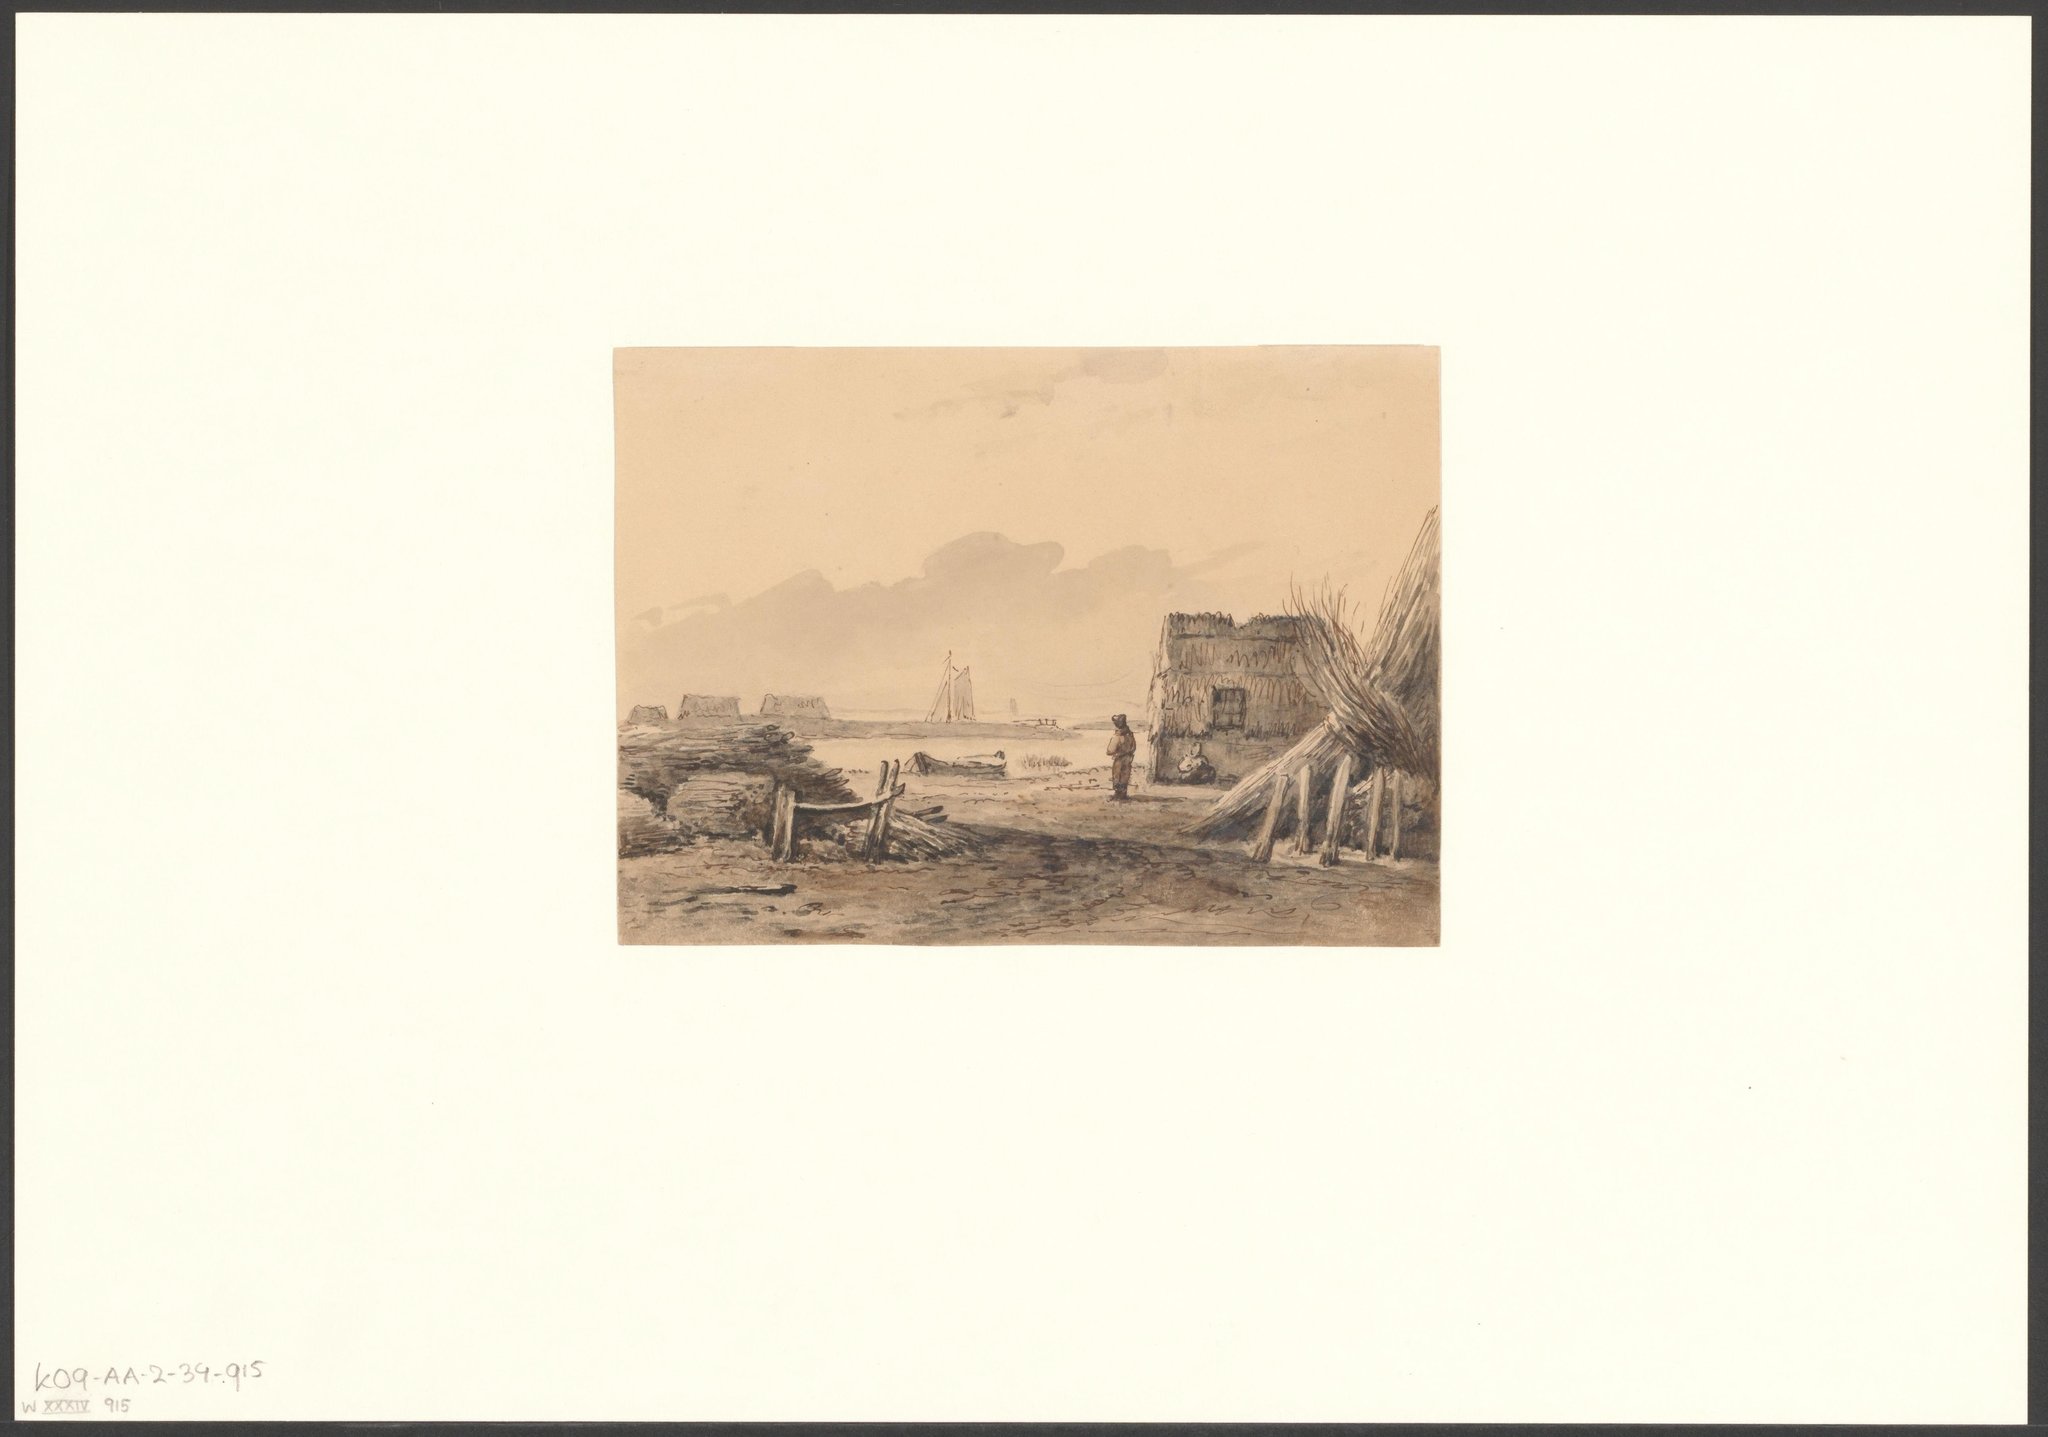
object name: drawing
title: Gezicht op de Buiksloterham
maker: cornelis steffelaar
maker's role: draughtsman, painter, print maker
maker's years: 1797-1861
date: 1808-1849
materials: ink, paper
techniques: brush, pen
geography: amsterdam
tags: city-view in general; 'veduta', polder, reclaimed land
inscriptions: inscription: ‘de Buiksloter Ham. / Augustus 1849.’, collector's mark: Lugt 800a, signature: ‘C. Steffelaar aan zijn Vriend / van Maurik’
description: Tekening binnen de Atlas Van Eck ingedeeld op wijknummer 34.